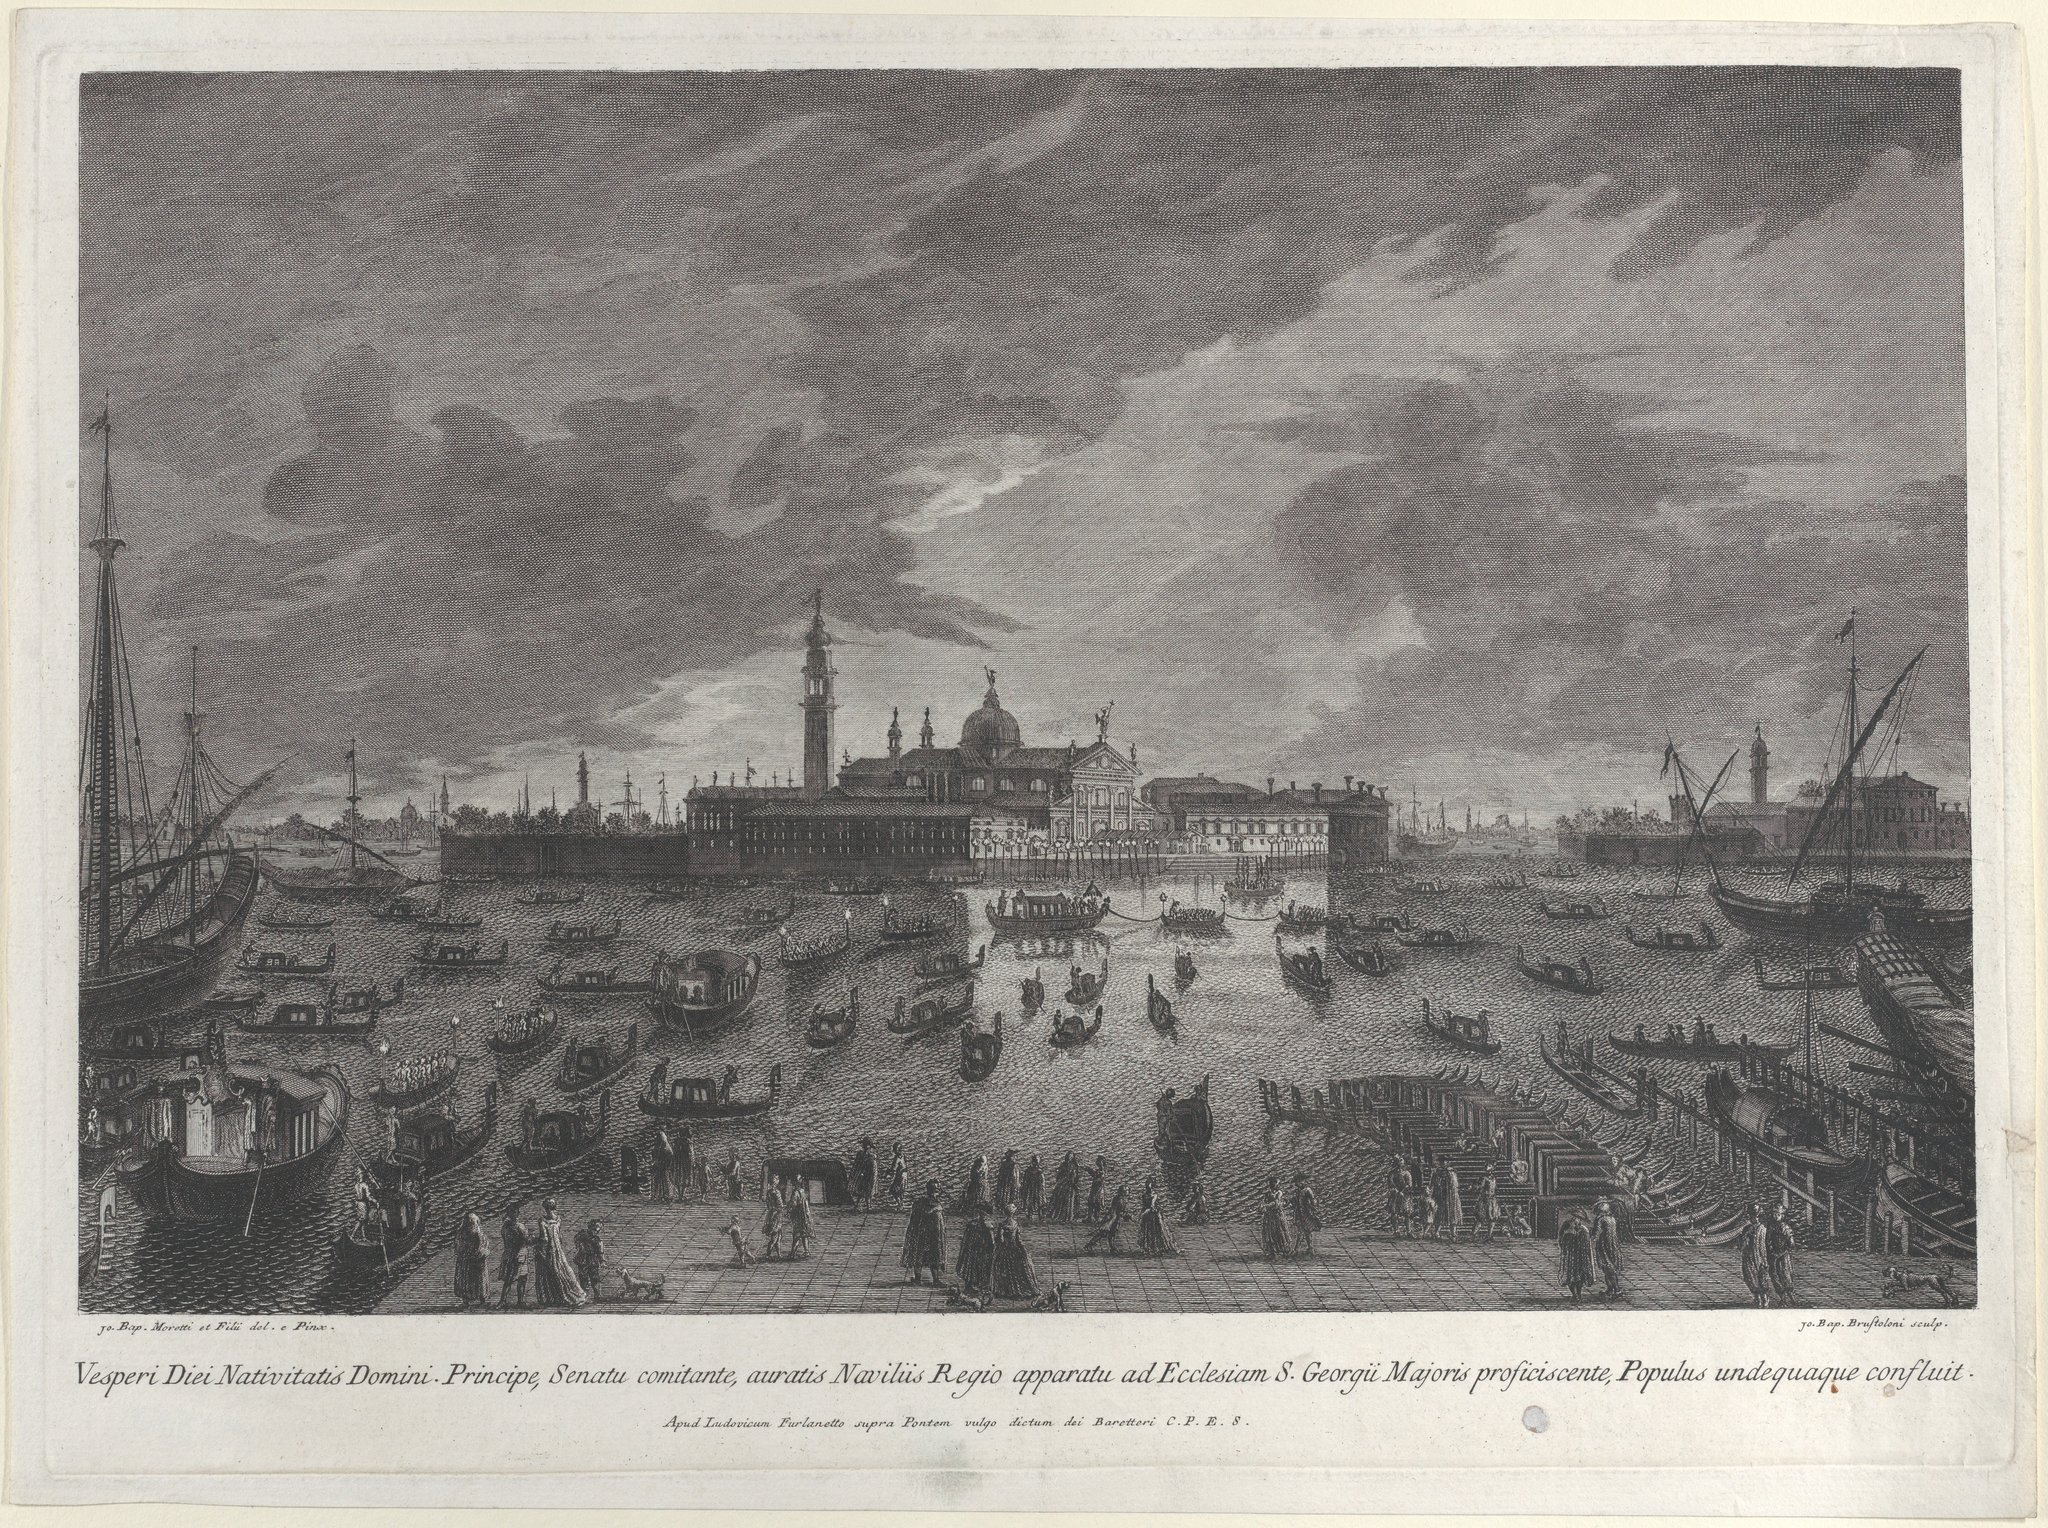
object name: print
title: Nocturnal view of the procession on Christmas Eve of the Doge and Venetian Senate to San Giorgio Maggiore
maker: giovanni battista brustolon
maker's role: artist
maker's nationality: italian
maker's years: 1712-1796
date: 1763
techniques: etching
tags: venice